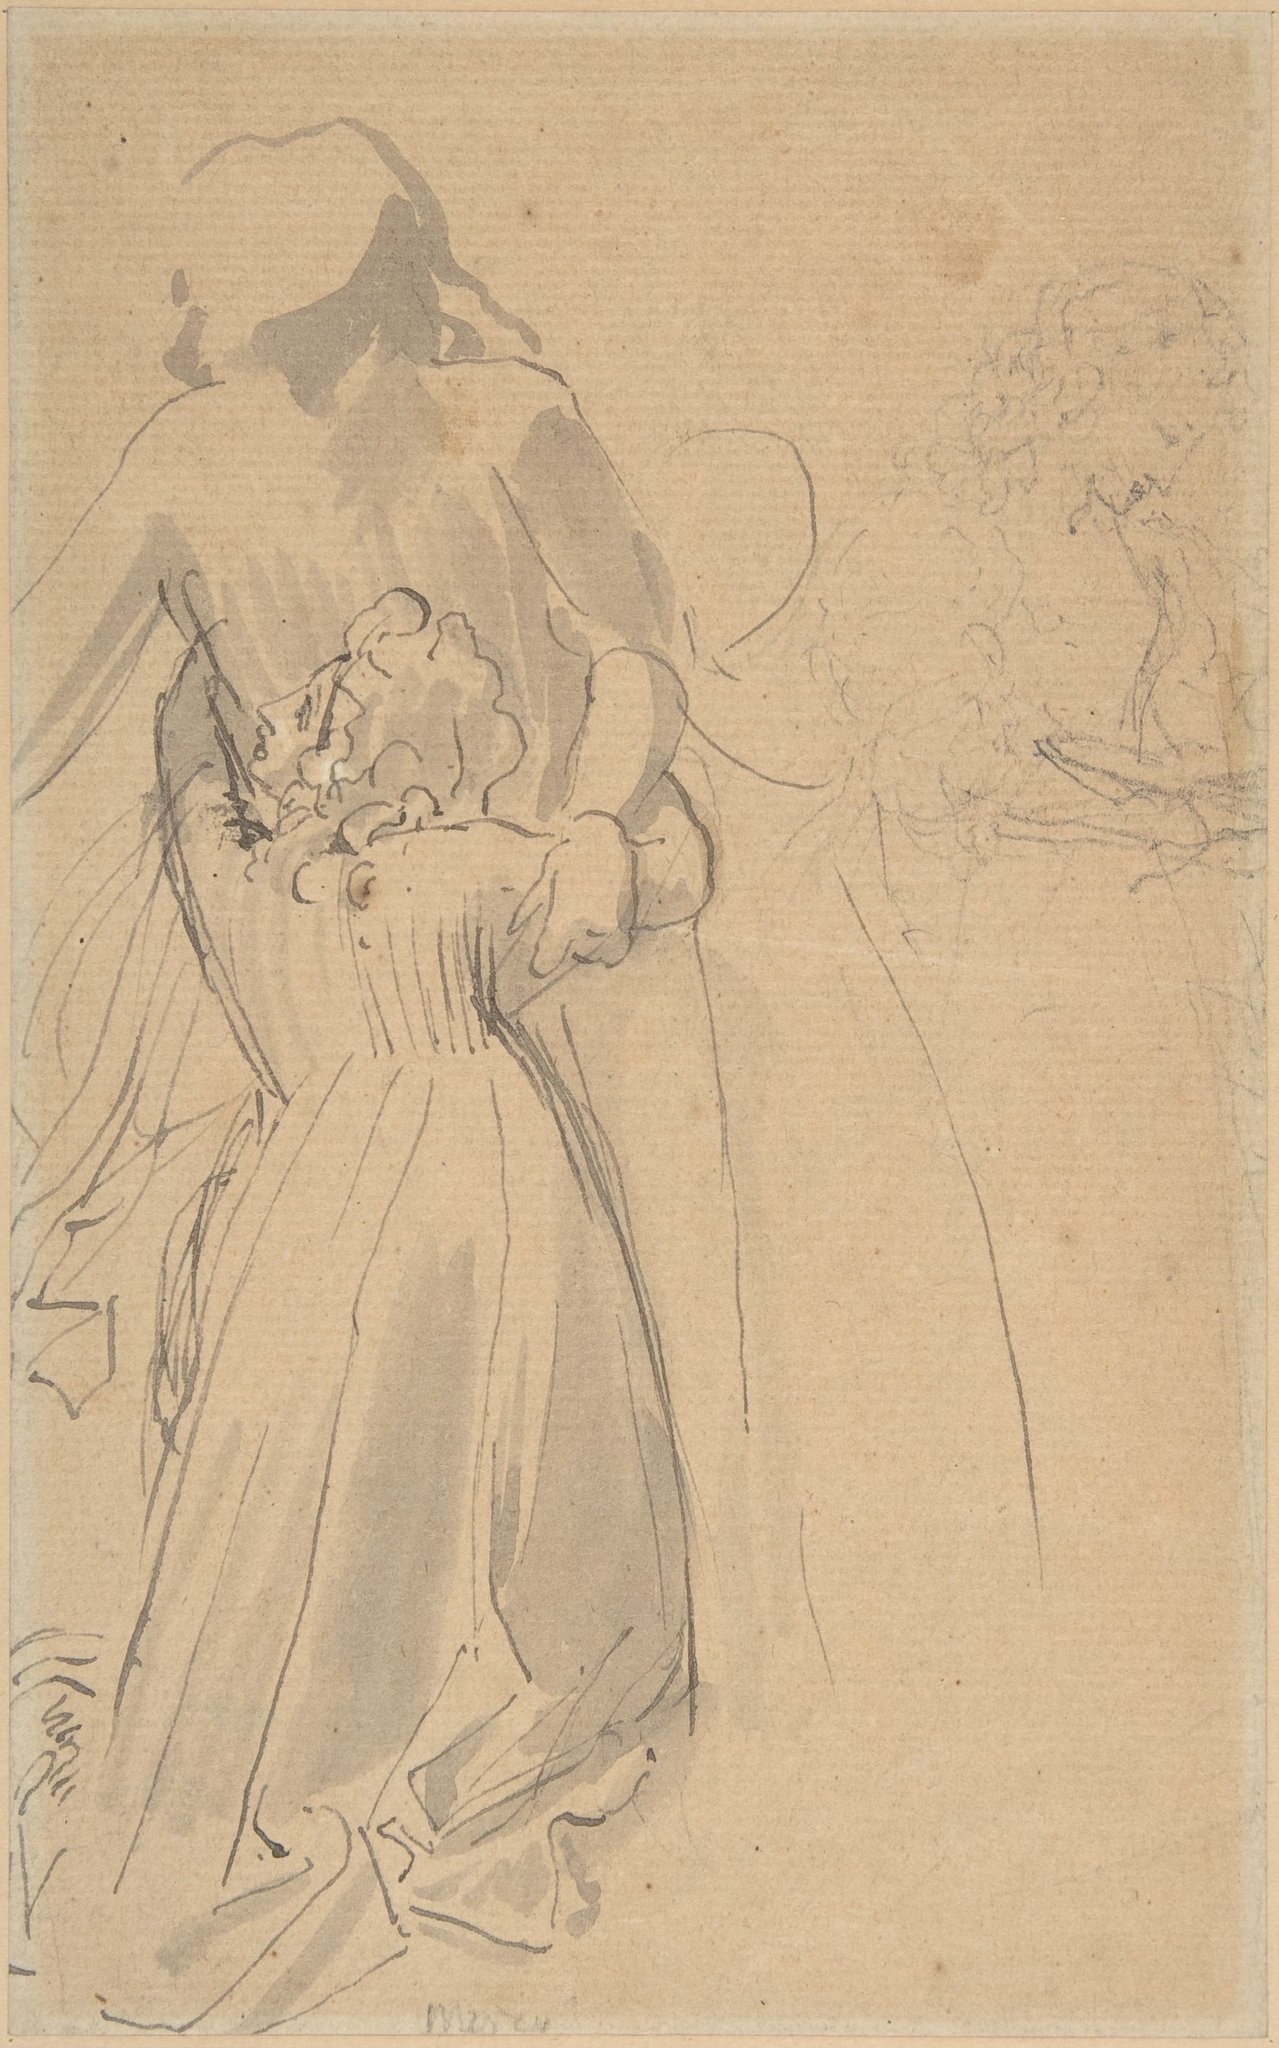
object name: drawing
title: Sheet of studies with female figure kneeling and embracing standing figure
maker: john flaxman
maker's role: artist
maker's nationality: british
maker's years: 1755-1826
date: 1775-1826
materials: graphite, ink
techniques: brush, pen, wash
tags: women